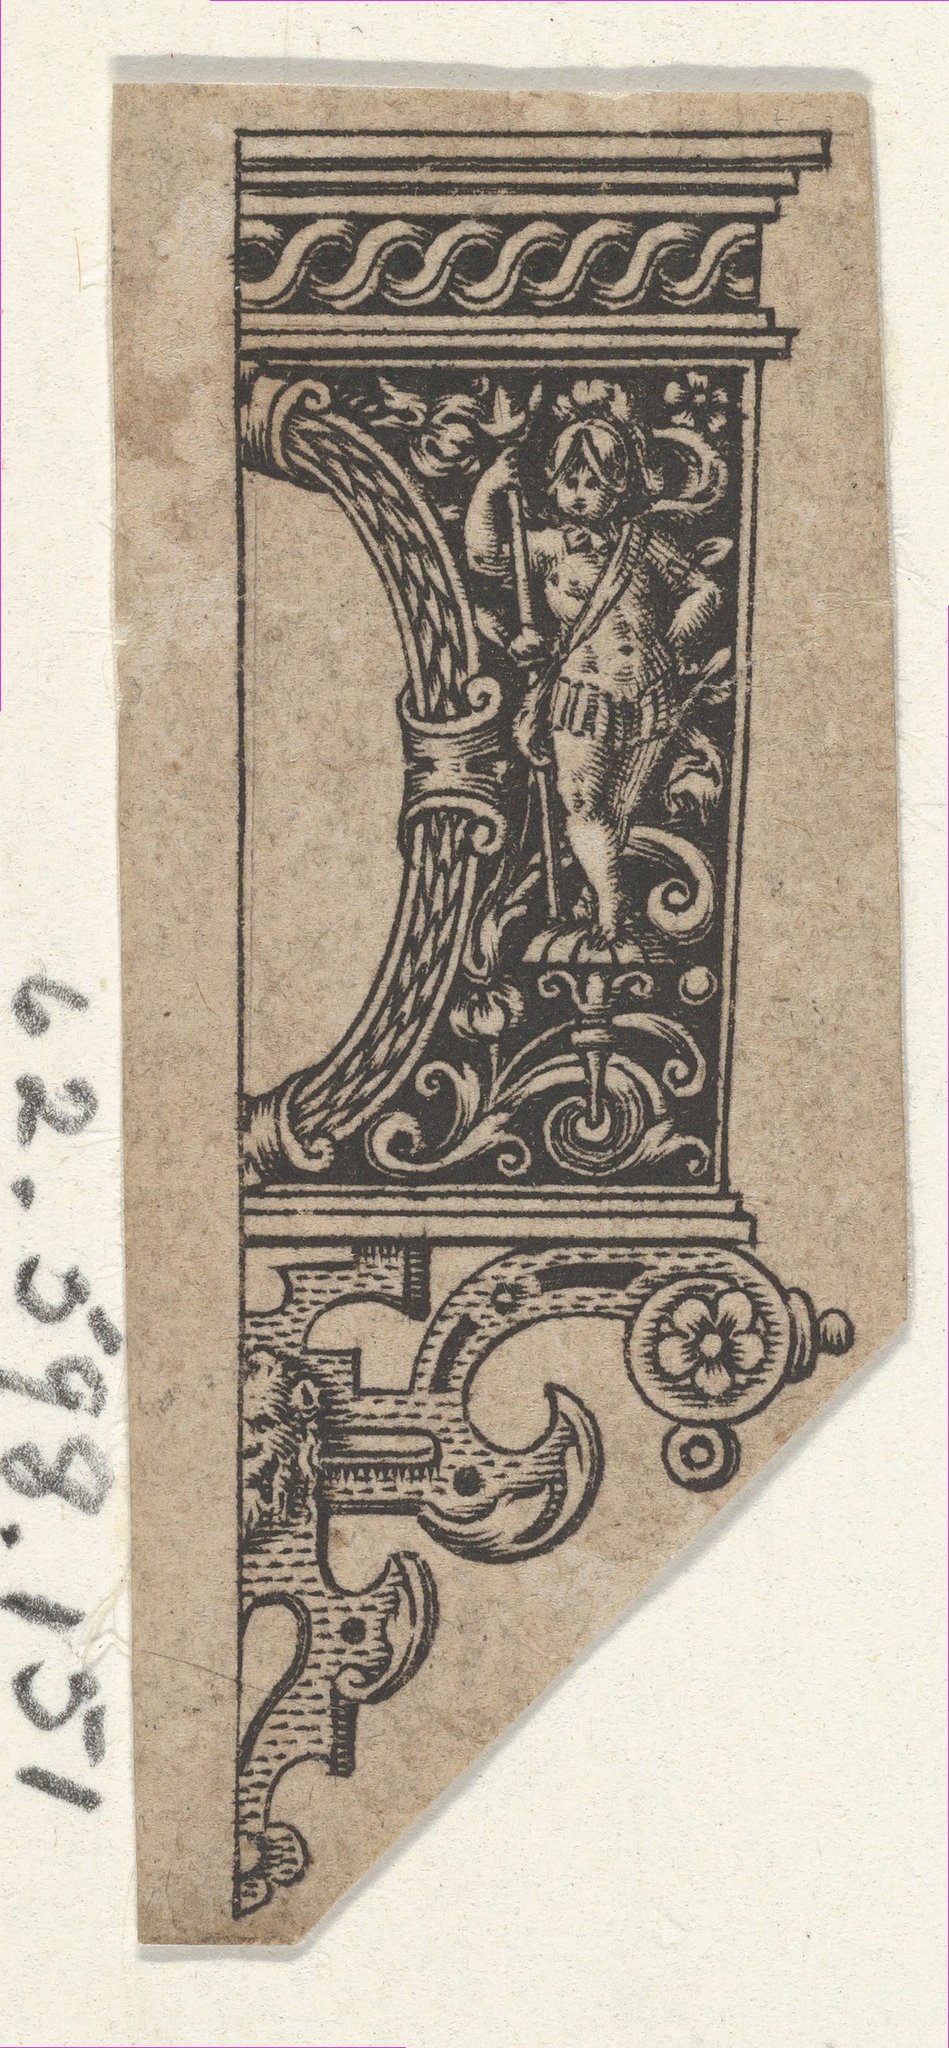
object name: print ornament architecture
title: Design for a Knife Handle (Fragment from Manches de Coutiaus)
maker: johann theodor de bry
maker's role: artist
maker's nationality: netherlandish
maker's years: 1561-1623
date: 1580-1600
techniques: embroidery, engraving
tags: human figures,hilts